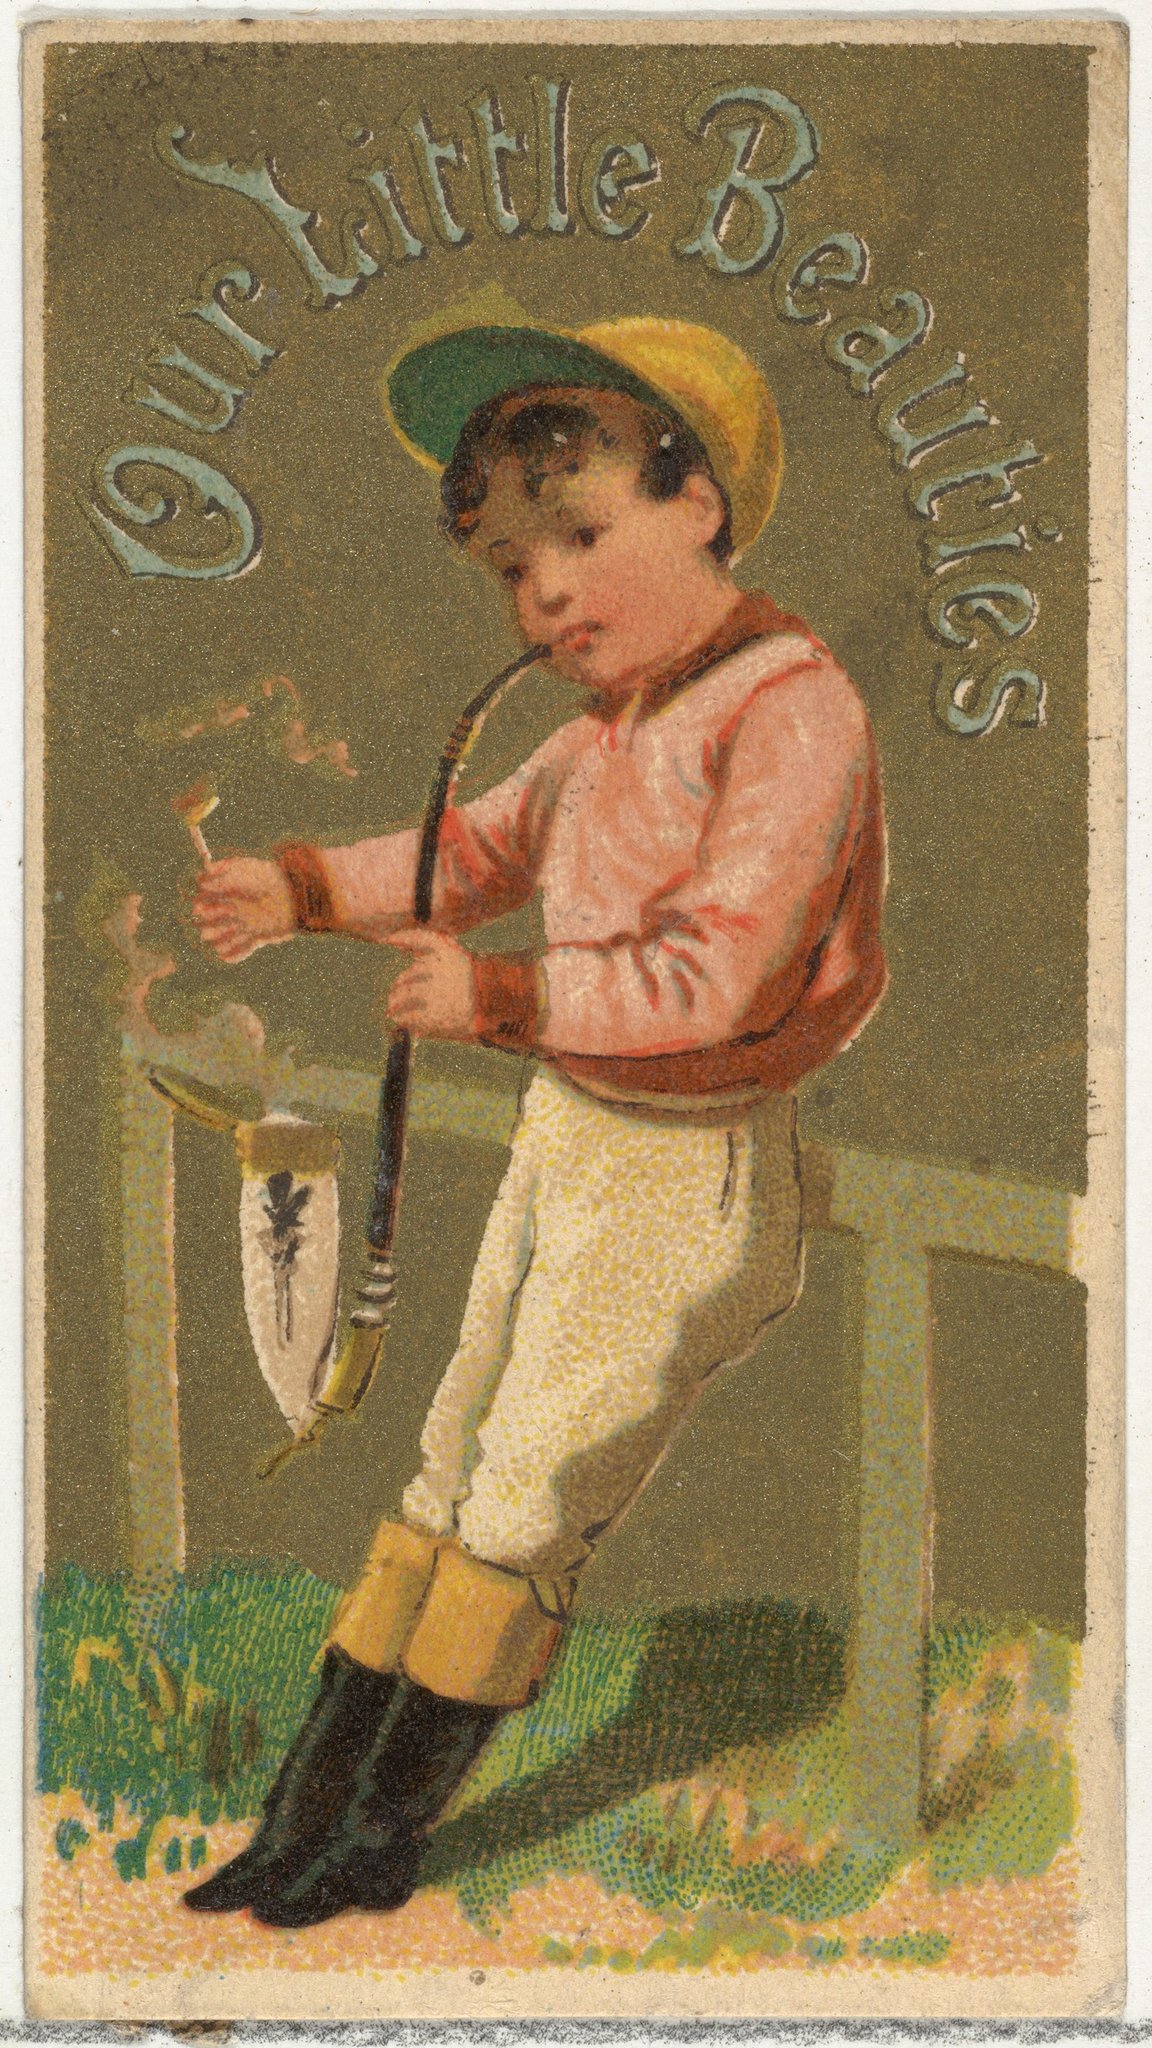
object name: print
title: From the Girls and Children series (N58) promoting Our Little Beauties Cigarettes for Allen & Ginter brand tobacco products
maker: allen & ginter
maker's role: publisher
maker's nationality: american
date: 1887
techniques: color lithograph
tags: girls,smoking